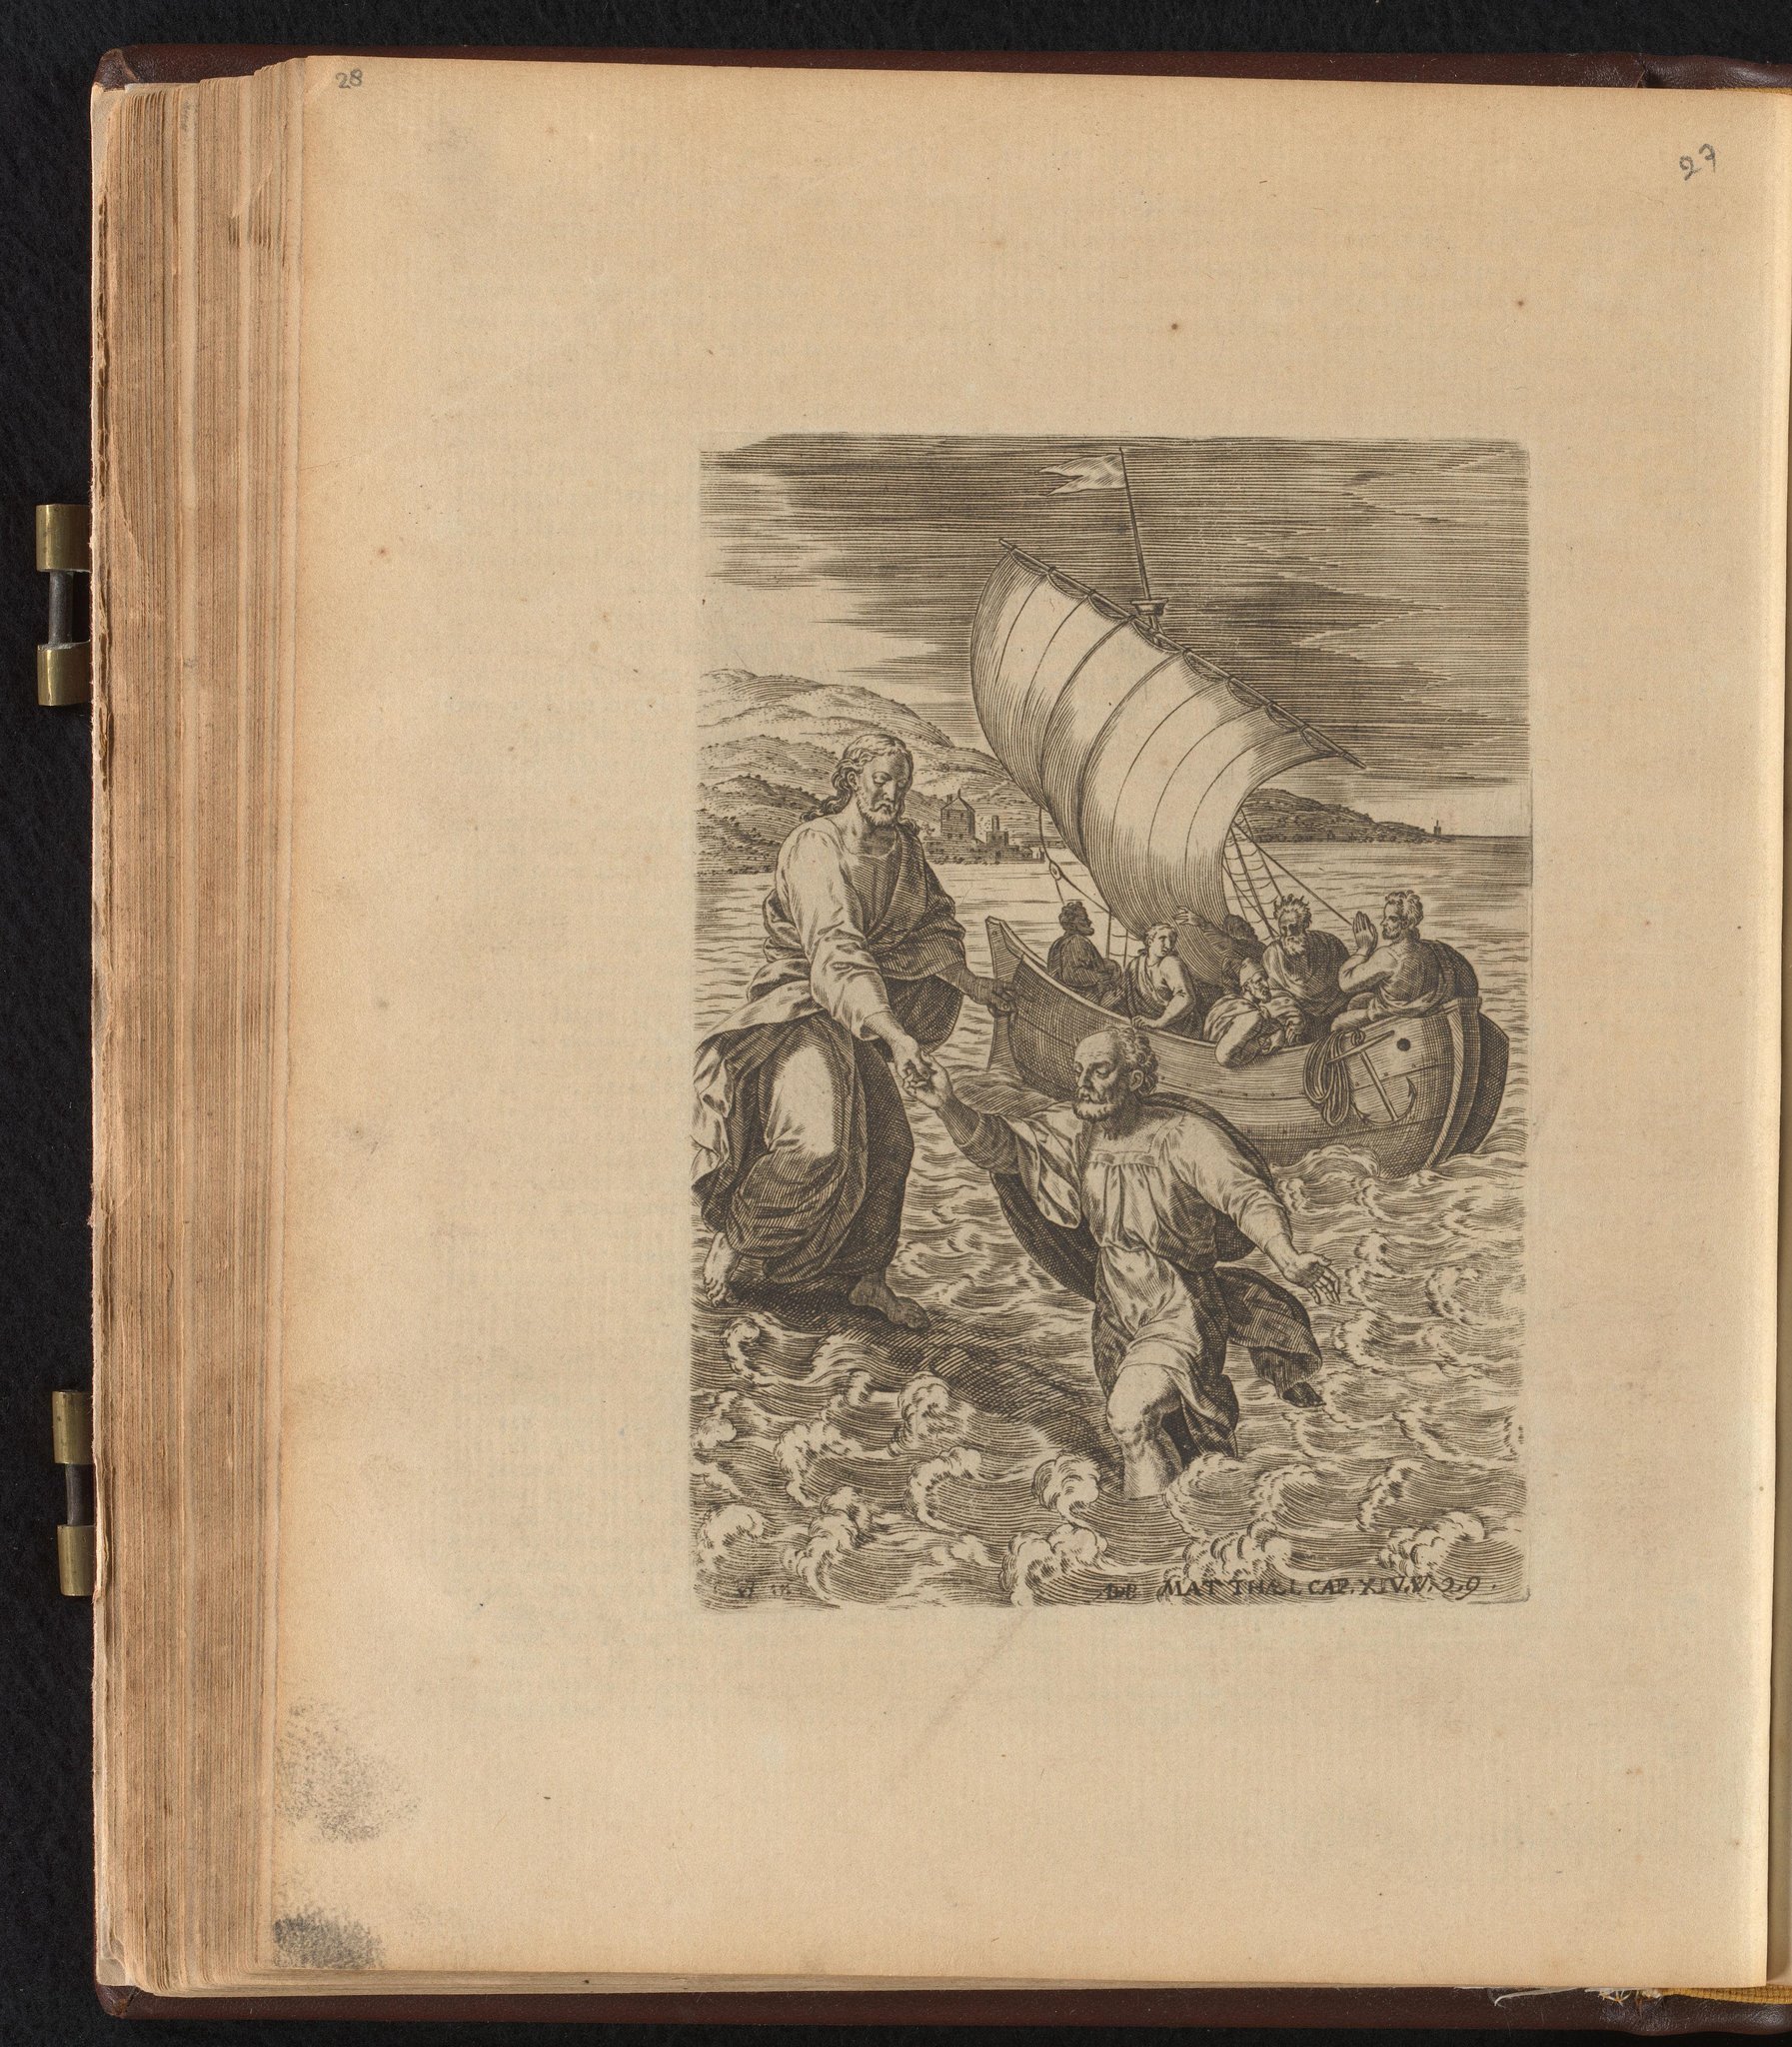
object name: print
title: Christus en zijn leerlingen in de storm op het meer van Galilea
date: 1583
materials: paper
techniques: engraving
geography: antwerp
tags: peter steps out of the boat and tries to walk on the water towards christ, christ saves peter from drowning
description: Prent ook gebruikt als boekillustratie in: Biblia Sacra. Antwerpen: Christoffel Plantijn, 1583.